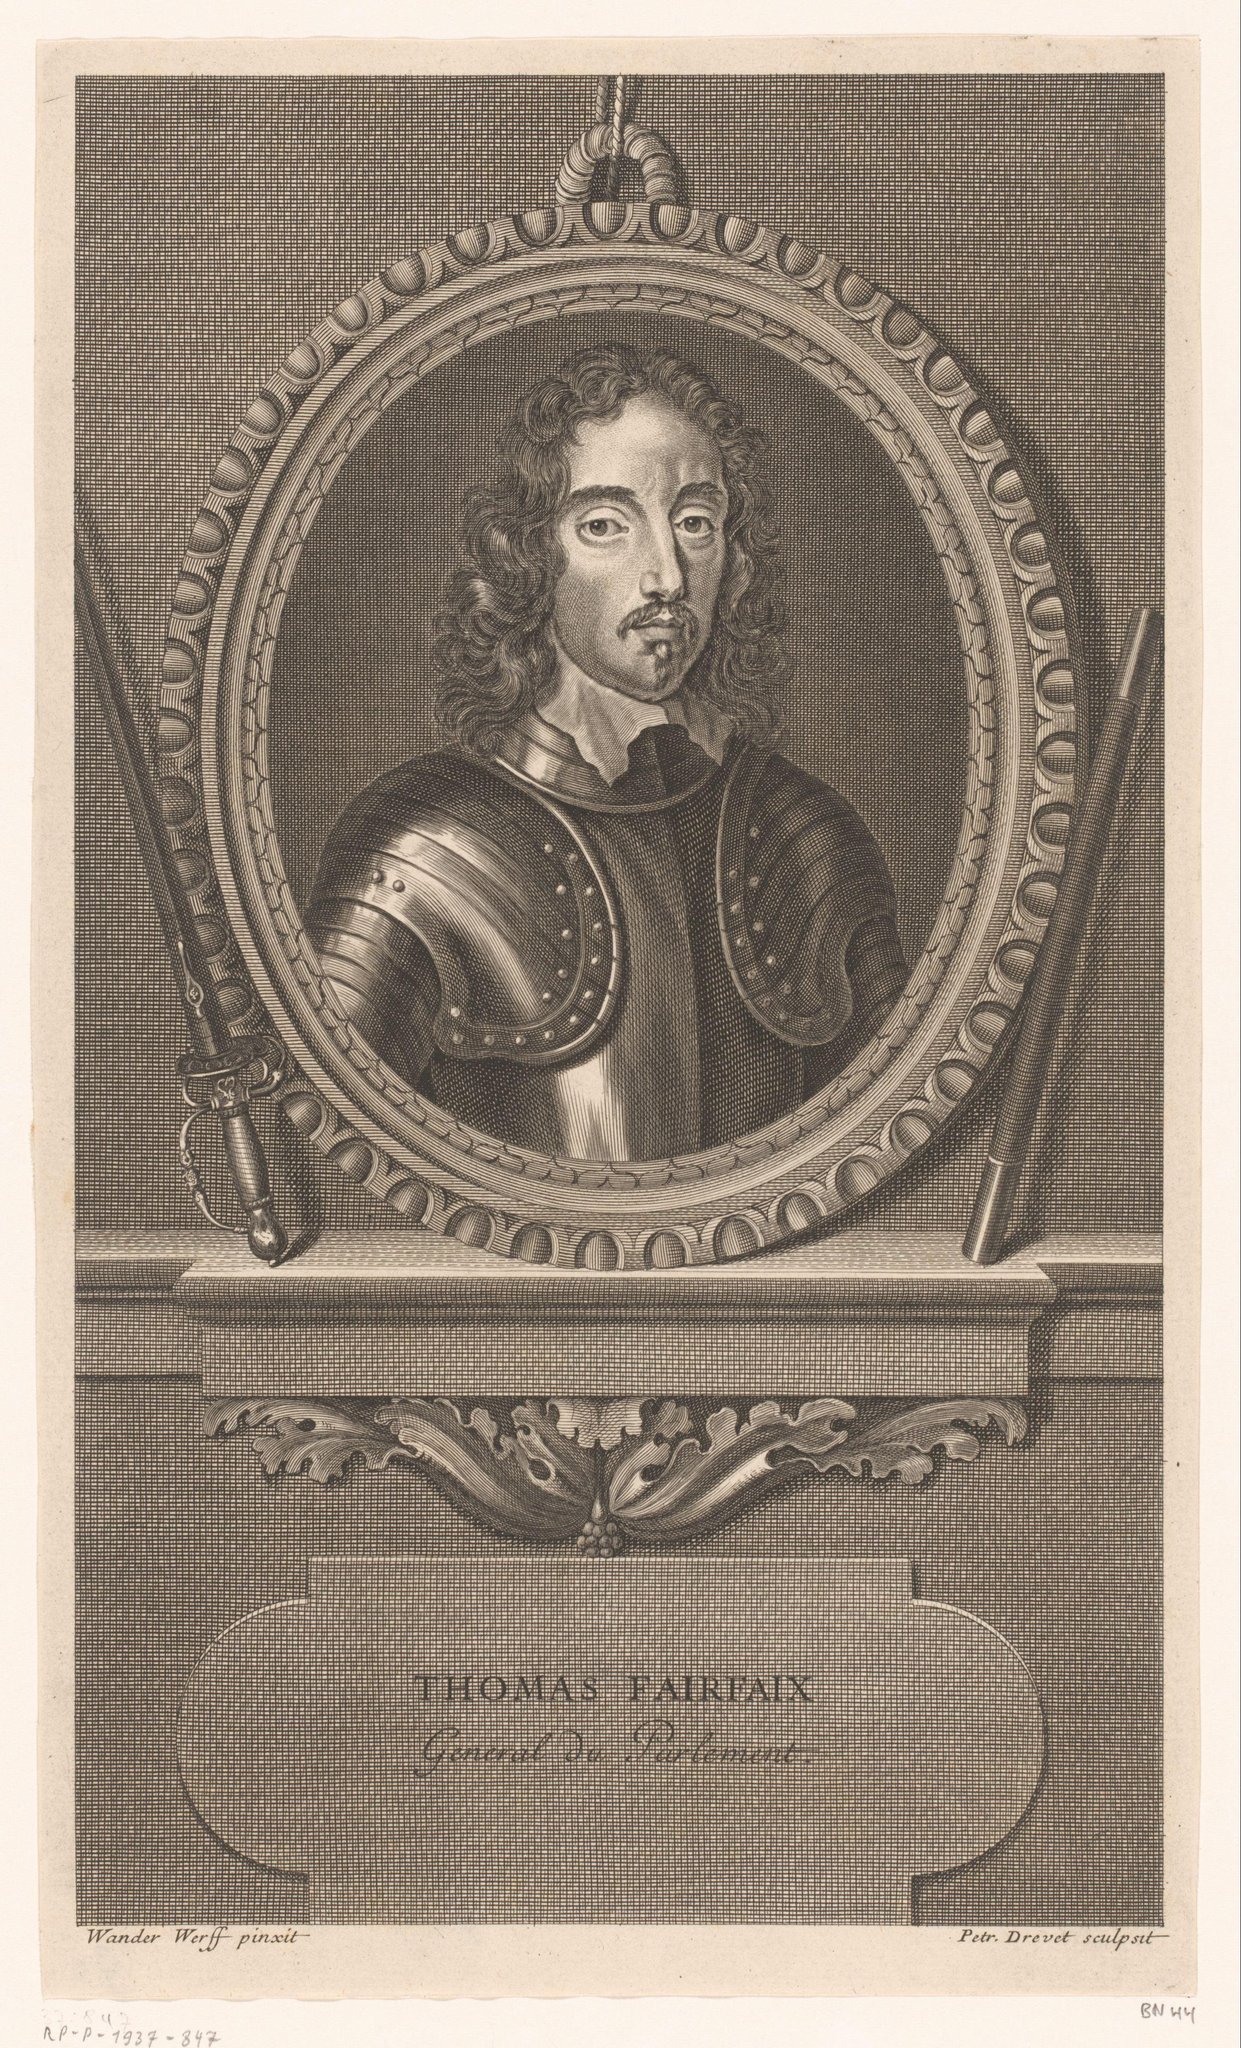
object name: print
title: Portret van Thomas Fairfax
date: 1673-1738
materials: paper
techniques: engraving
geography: france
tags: ornament ~ medallion, historical persons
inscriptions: collector's mark: Lugt 2228